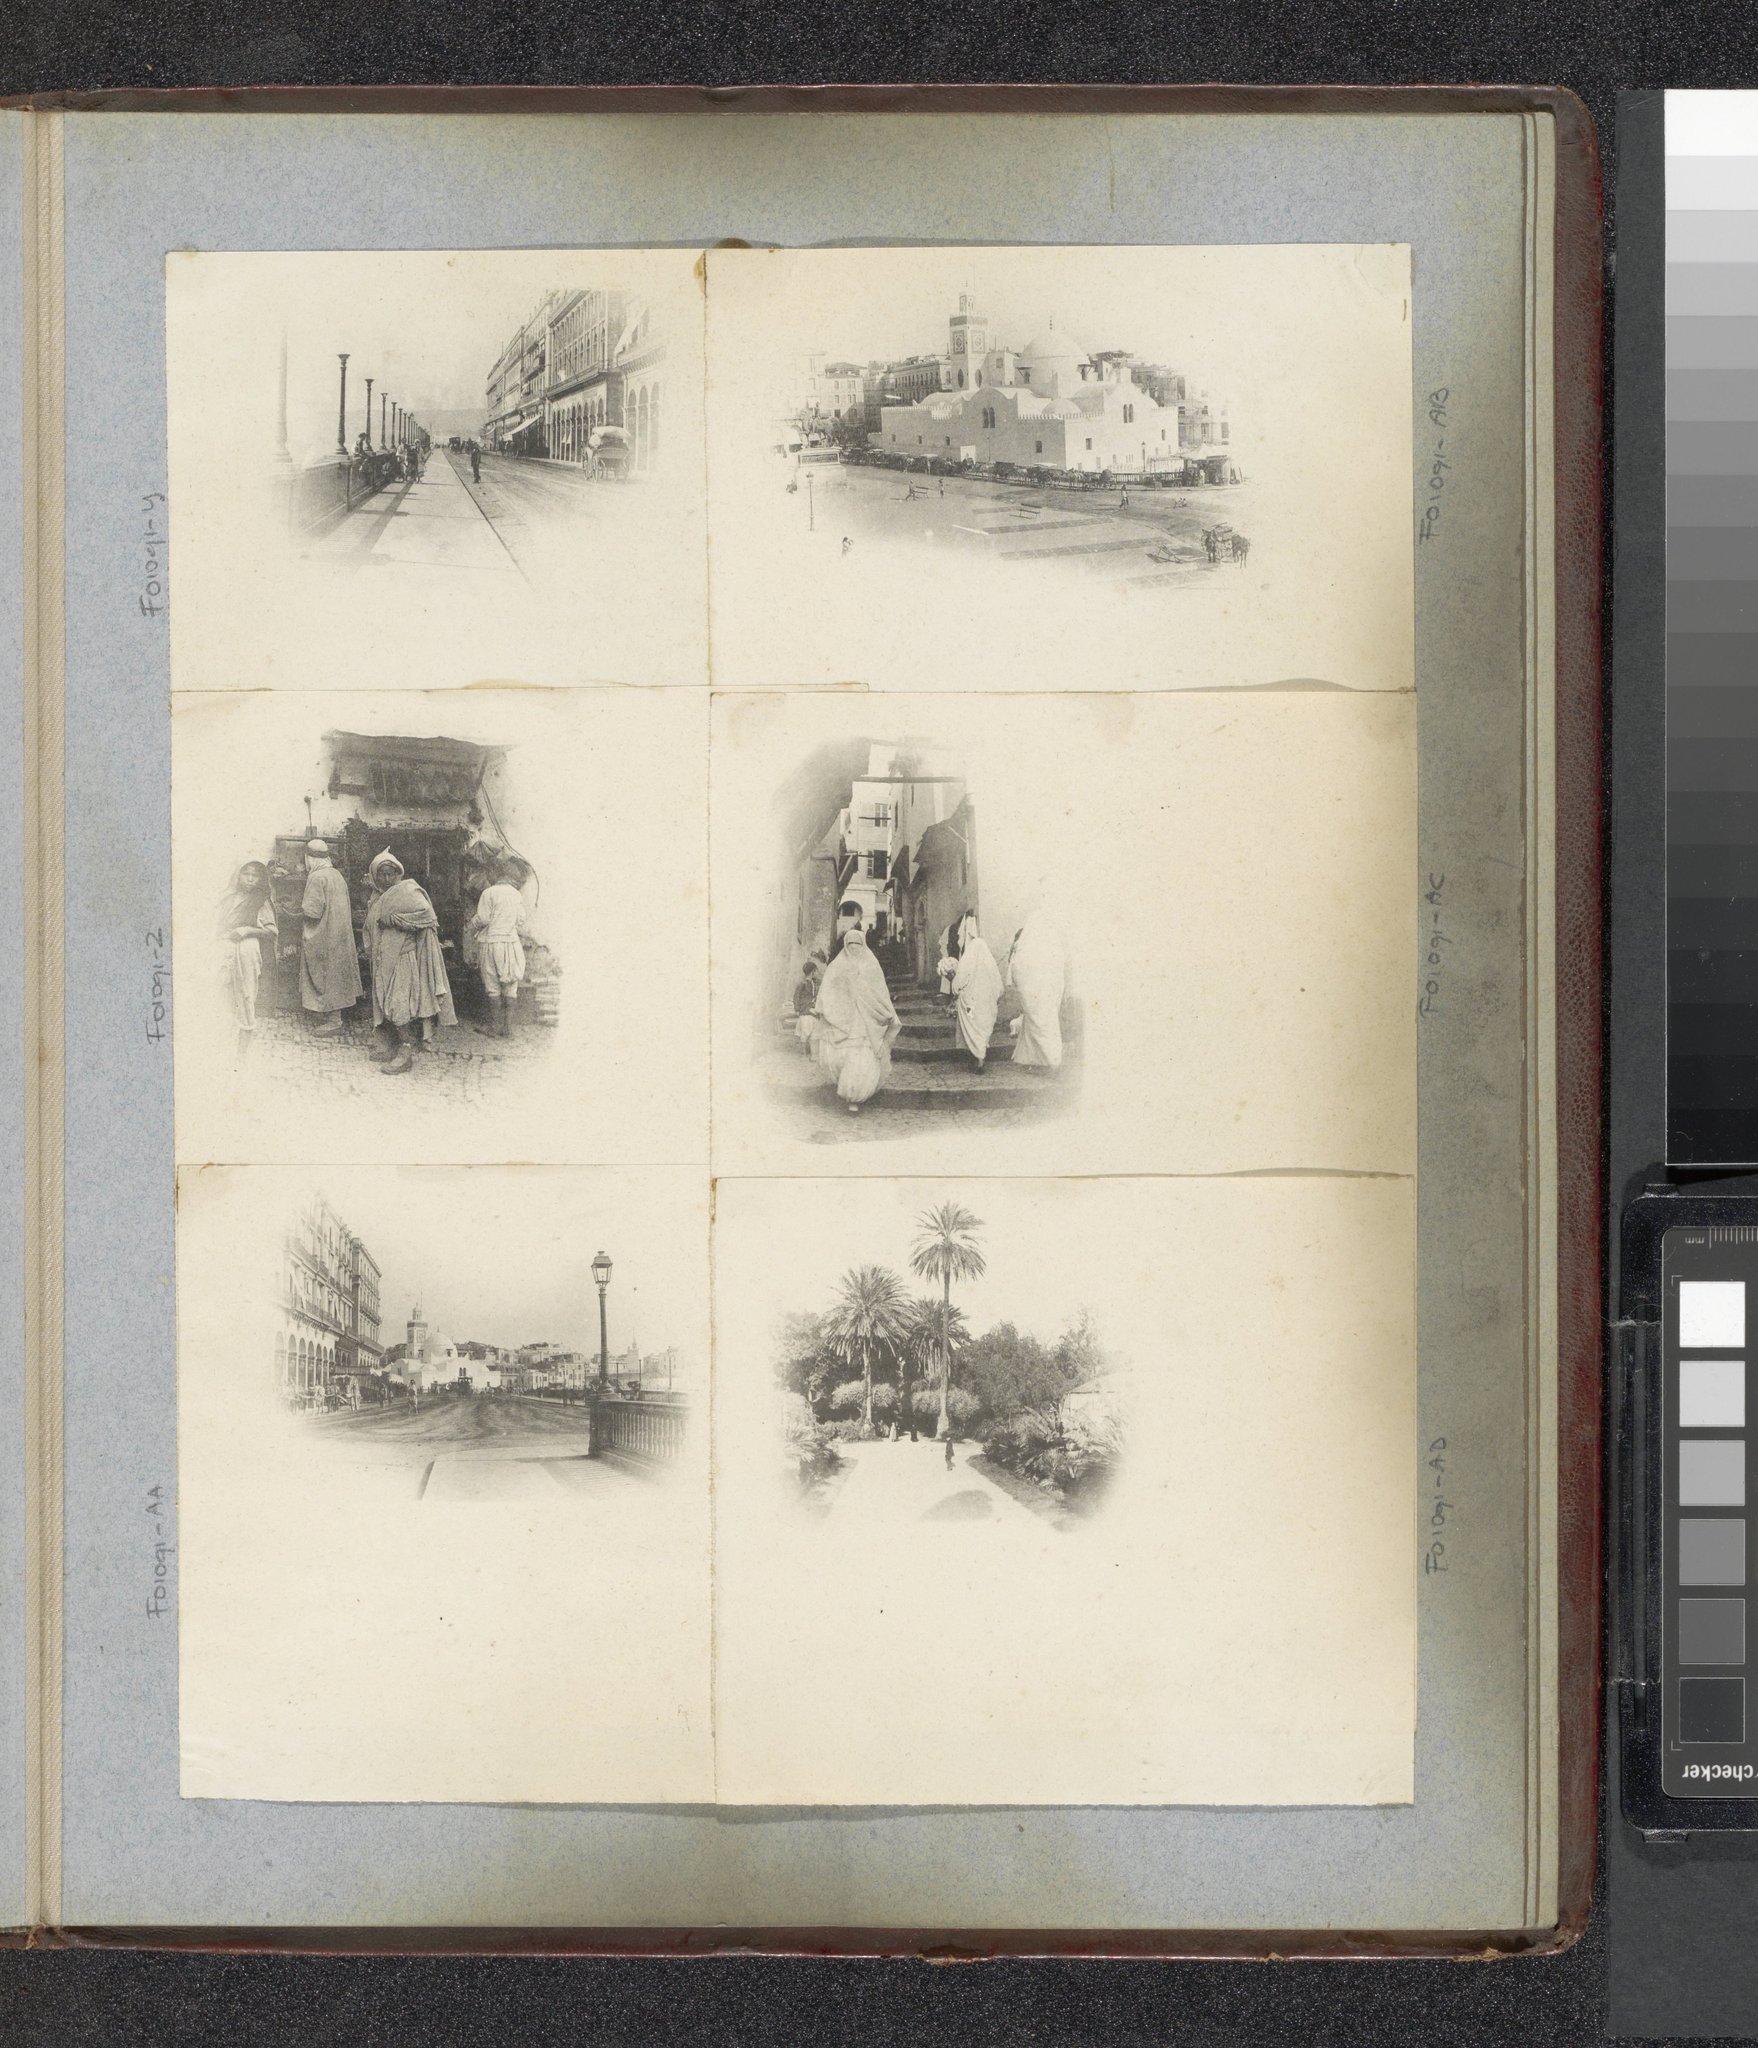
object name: photograph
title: Exterieur van een moskee in Tunesië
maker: Anonymous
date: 1880-1900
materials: paper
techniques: photograph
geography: tunisia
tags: temple, shrine ~ islam, mohammedanism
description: Onderdeel van Reisalbum met foto's van bezienswaardigheden in Tunis en Tunesië.